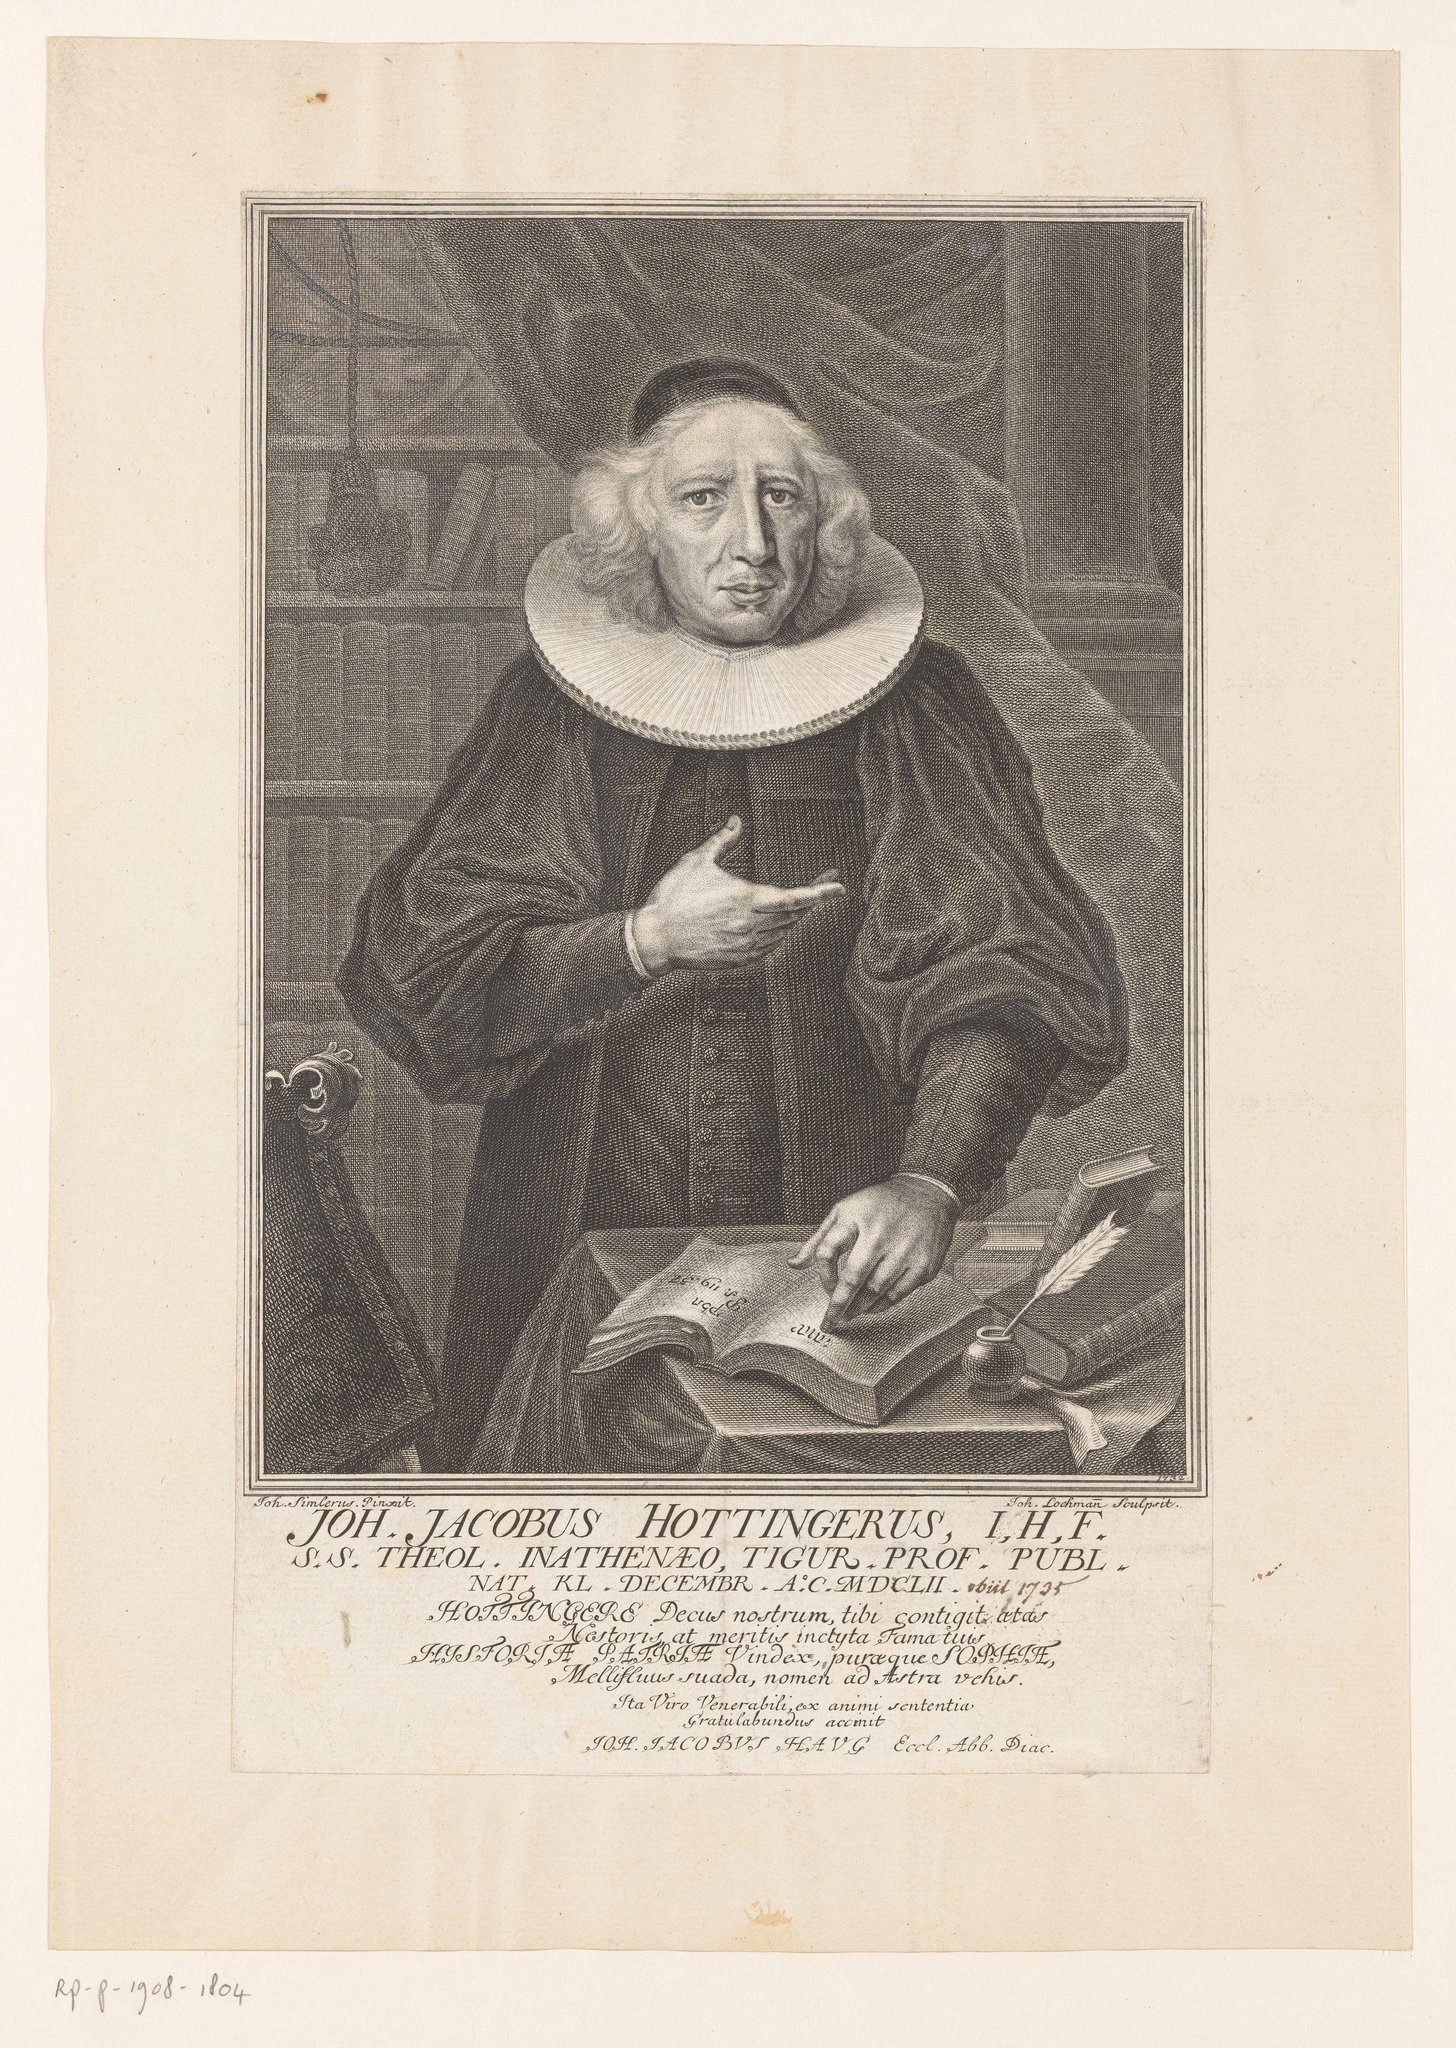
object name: print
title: Portret van Johann Jacob Hottinger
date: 1710-1762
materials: paper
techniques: engraving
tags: bookshelves, historical persons, writing accessories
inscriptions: collector's mark: Lugt 2228, : ‘obiit 1735’